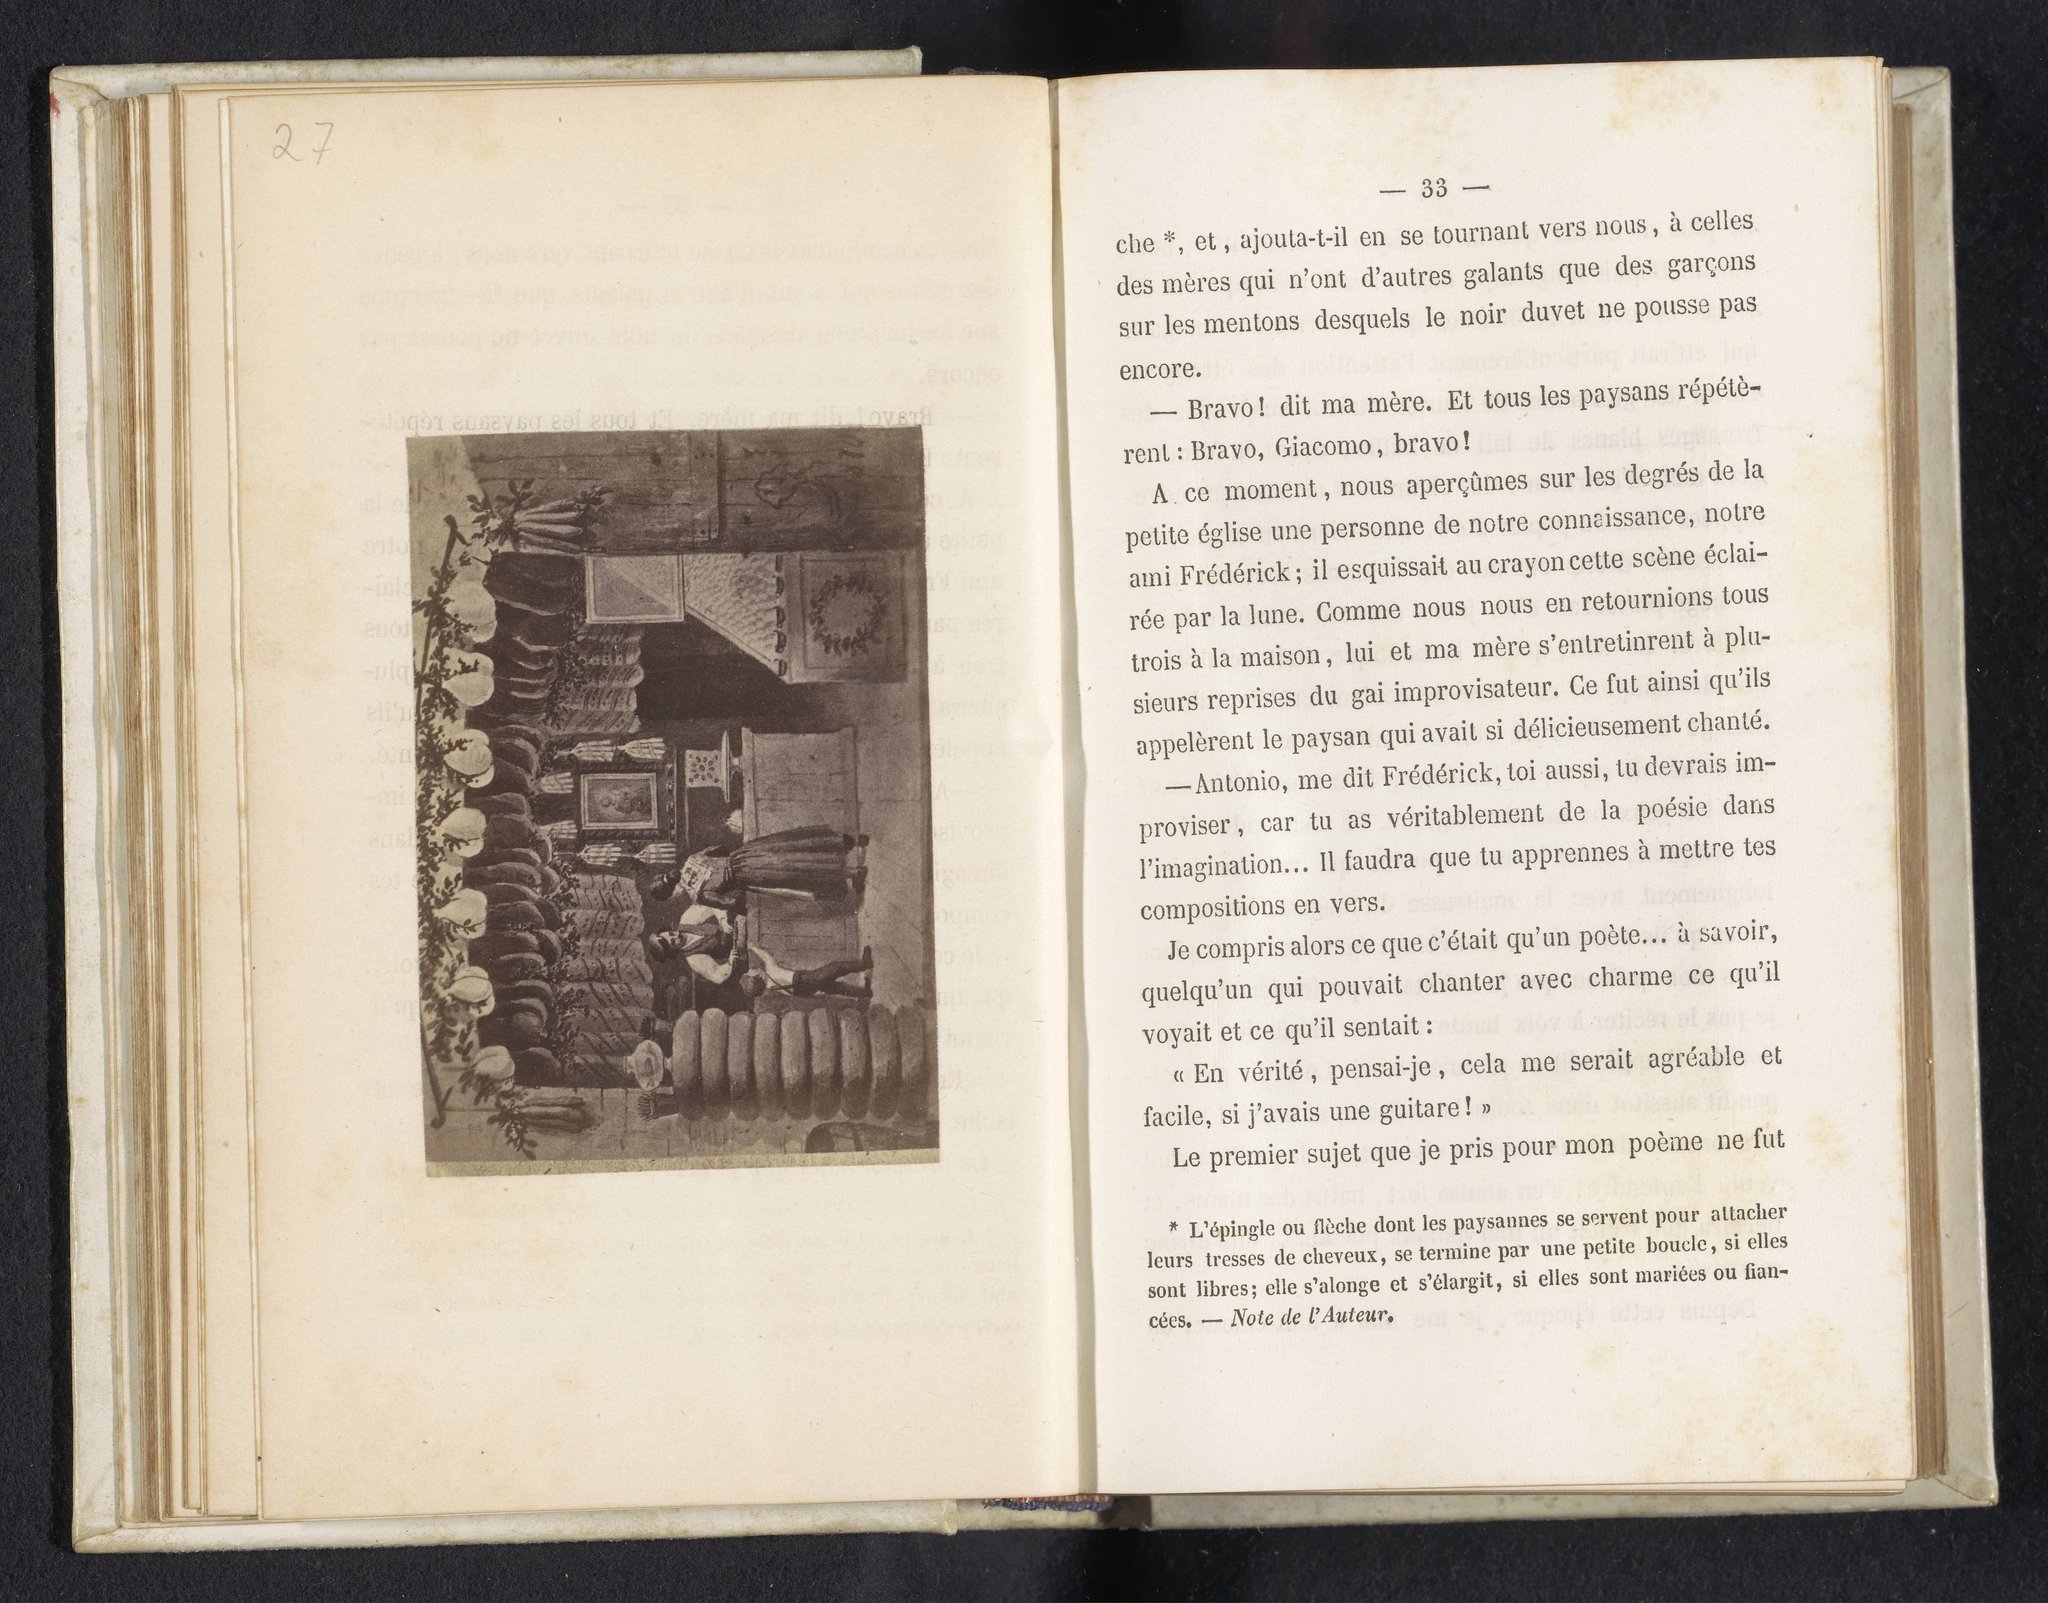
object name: photograph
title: Fotoreproductie van een schilderij, voorstellende een interieur van (vermoedelijk) een delicatessenzaak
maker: Anonymous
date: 1850-1860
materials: photographic support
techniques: albumen print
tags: shop, store